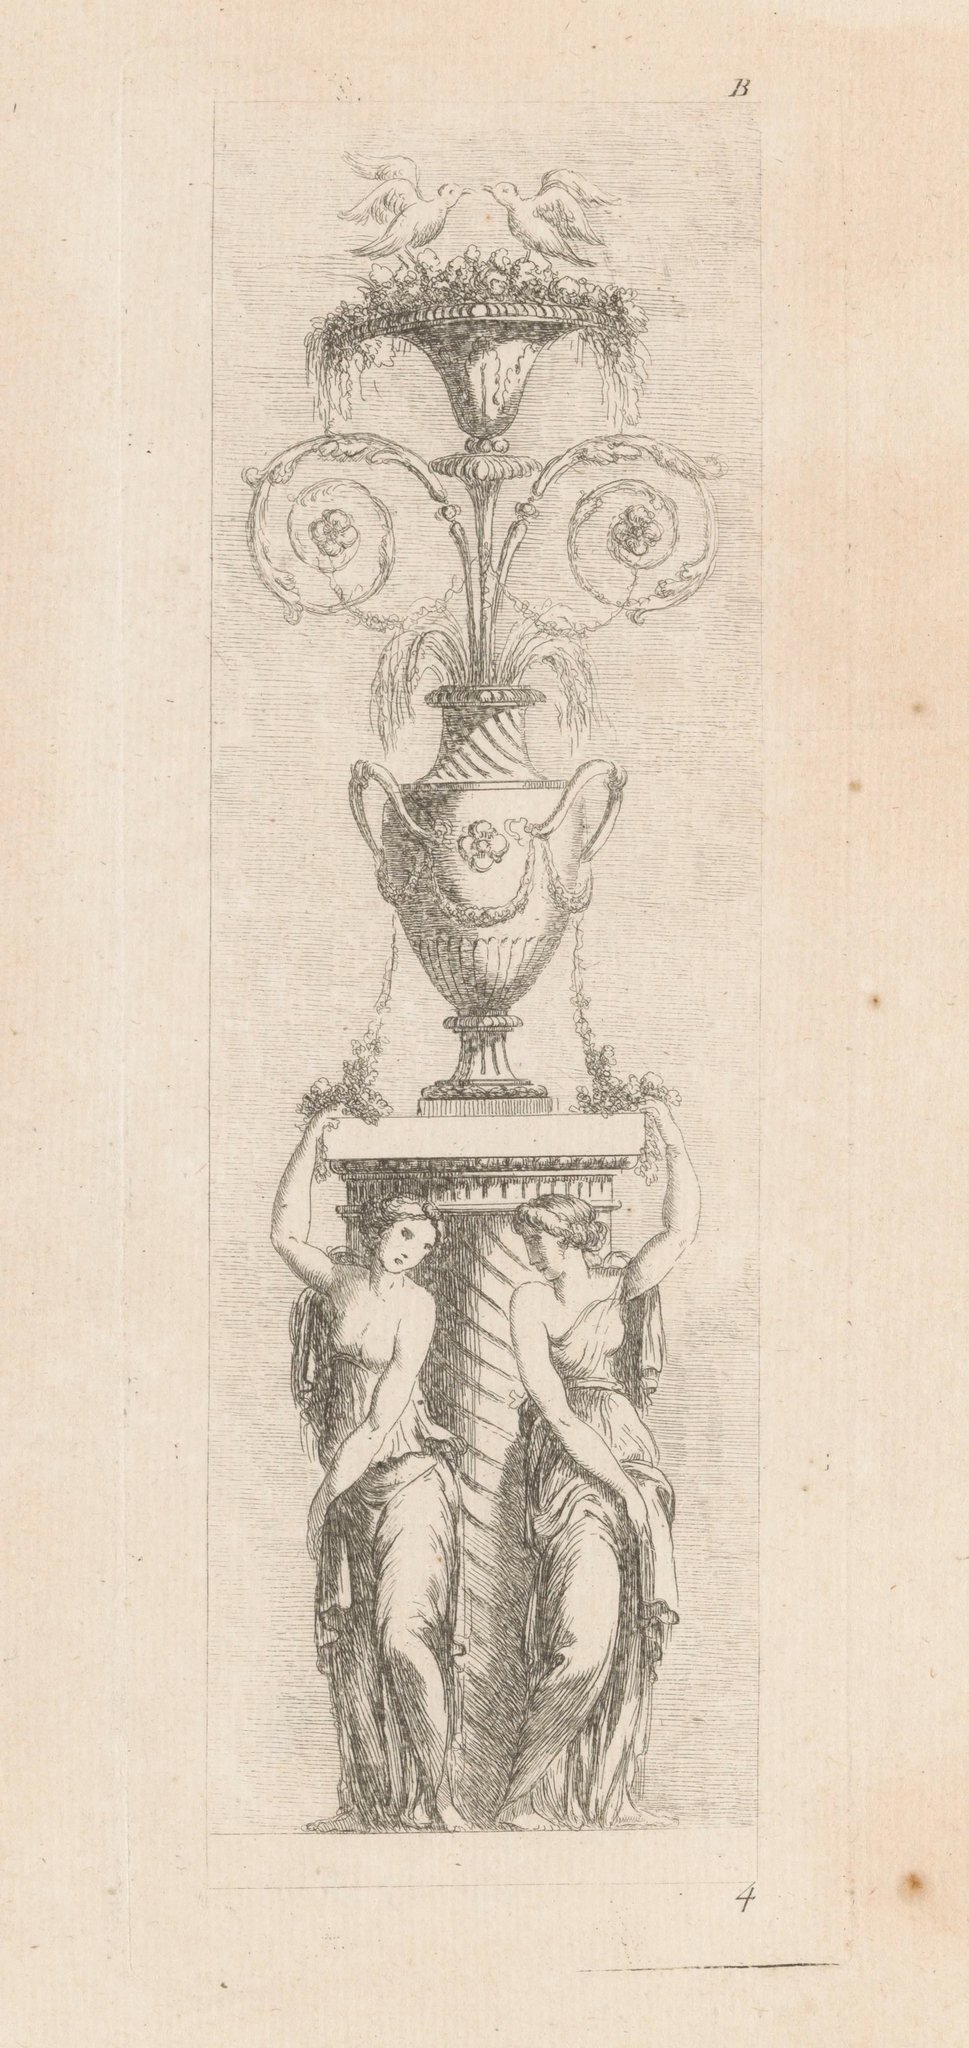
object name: print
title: Staande vrouwen met vazen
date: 1752-1782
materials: paper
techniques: etching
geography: paris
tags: ornament ~ arabesque, vase ~ ornament, standing figure - aa - female human figure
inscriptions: collector's mark: Lugt 2760, collector's mark: Lugt 2228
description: Twee vrouwen staan voor een voetstuk waarop een vaas met arabesken en een tweede vaas met bloemen staat, bovenop twee duiven.